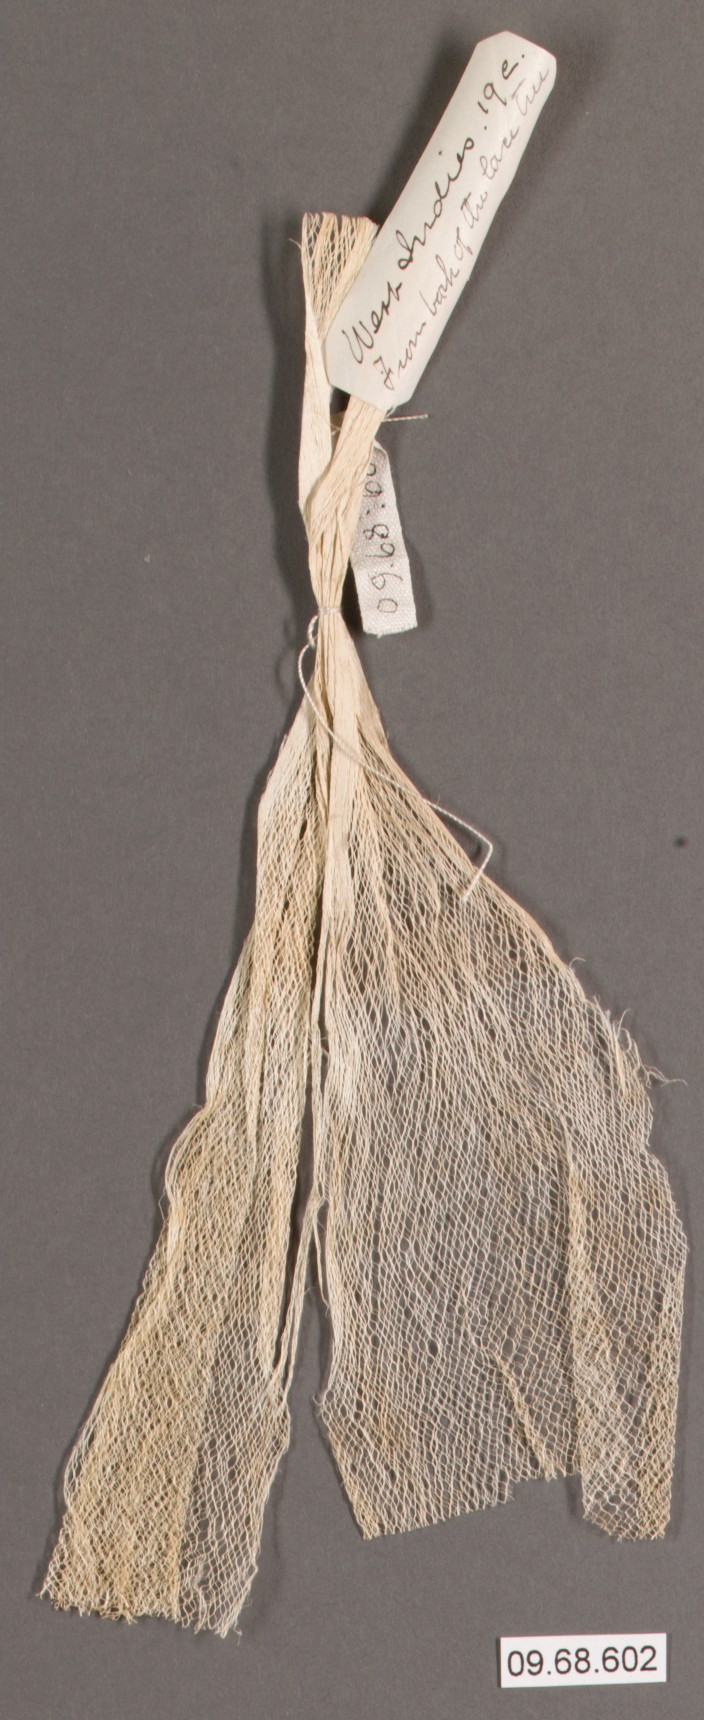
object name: fragment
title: Bark of a lace tree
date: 1801-1900